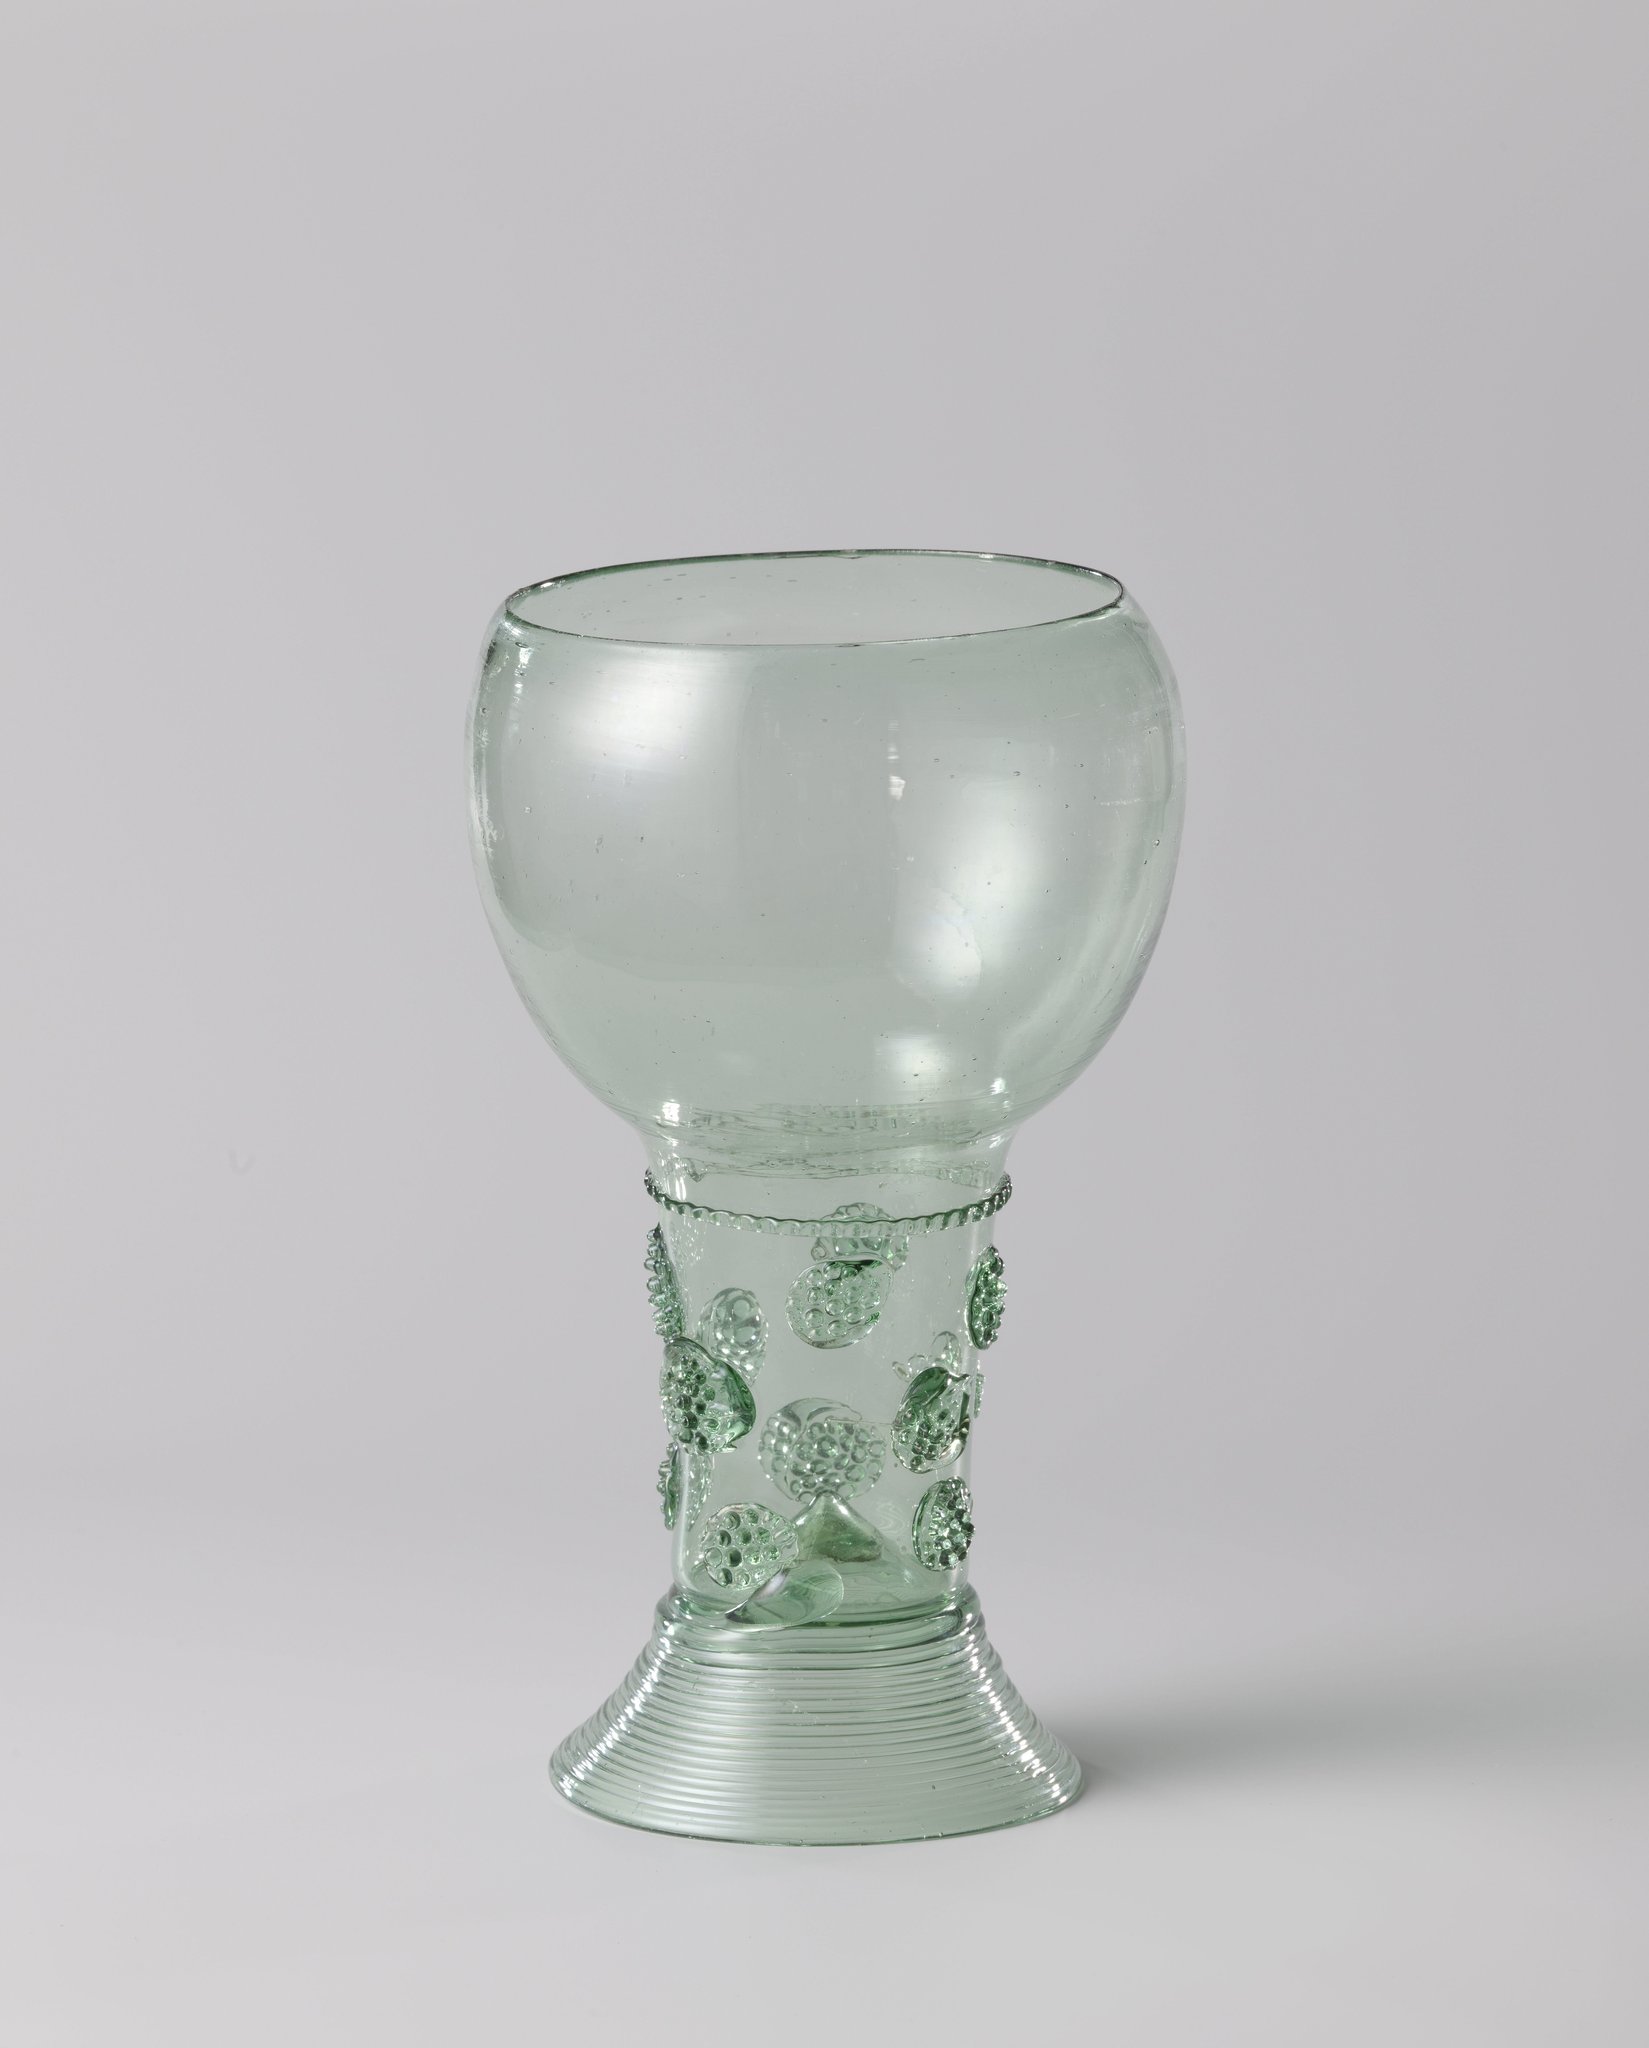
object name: roemer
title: Roemer met drie rijen braamnoppen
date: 1650-1700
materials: glass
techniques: glassblowing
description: Grote roemer met ingestoken bodem, op concave, uit een draad gesponnen voet. Bolle kelk, als één geheel geblazen met de holle stam, die bezet is met drie rijen braamnoppen. De overgang van de kelk naar de stam aangegeven door een geribde draad.